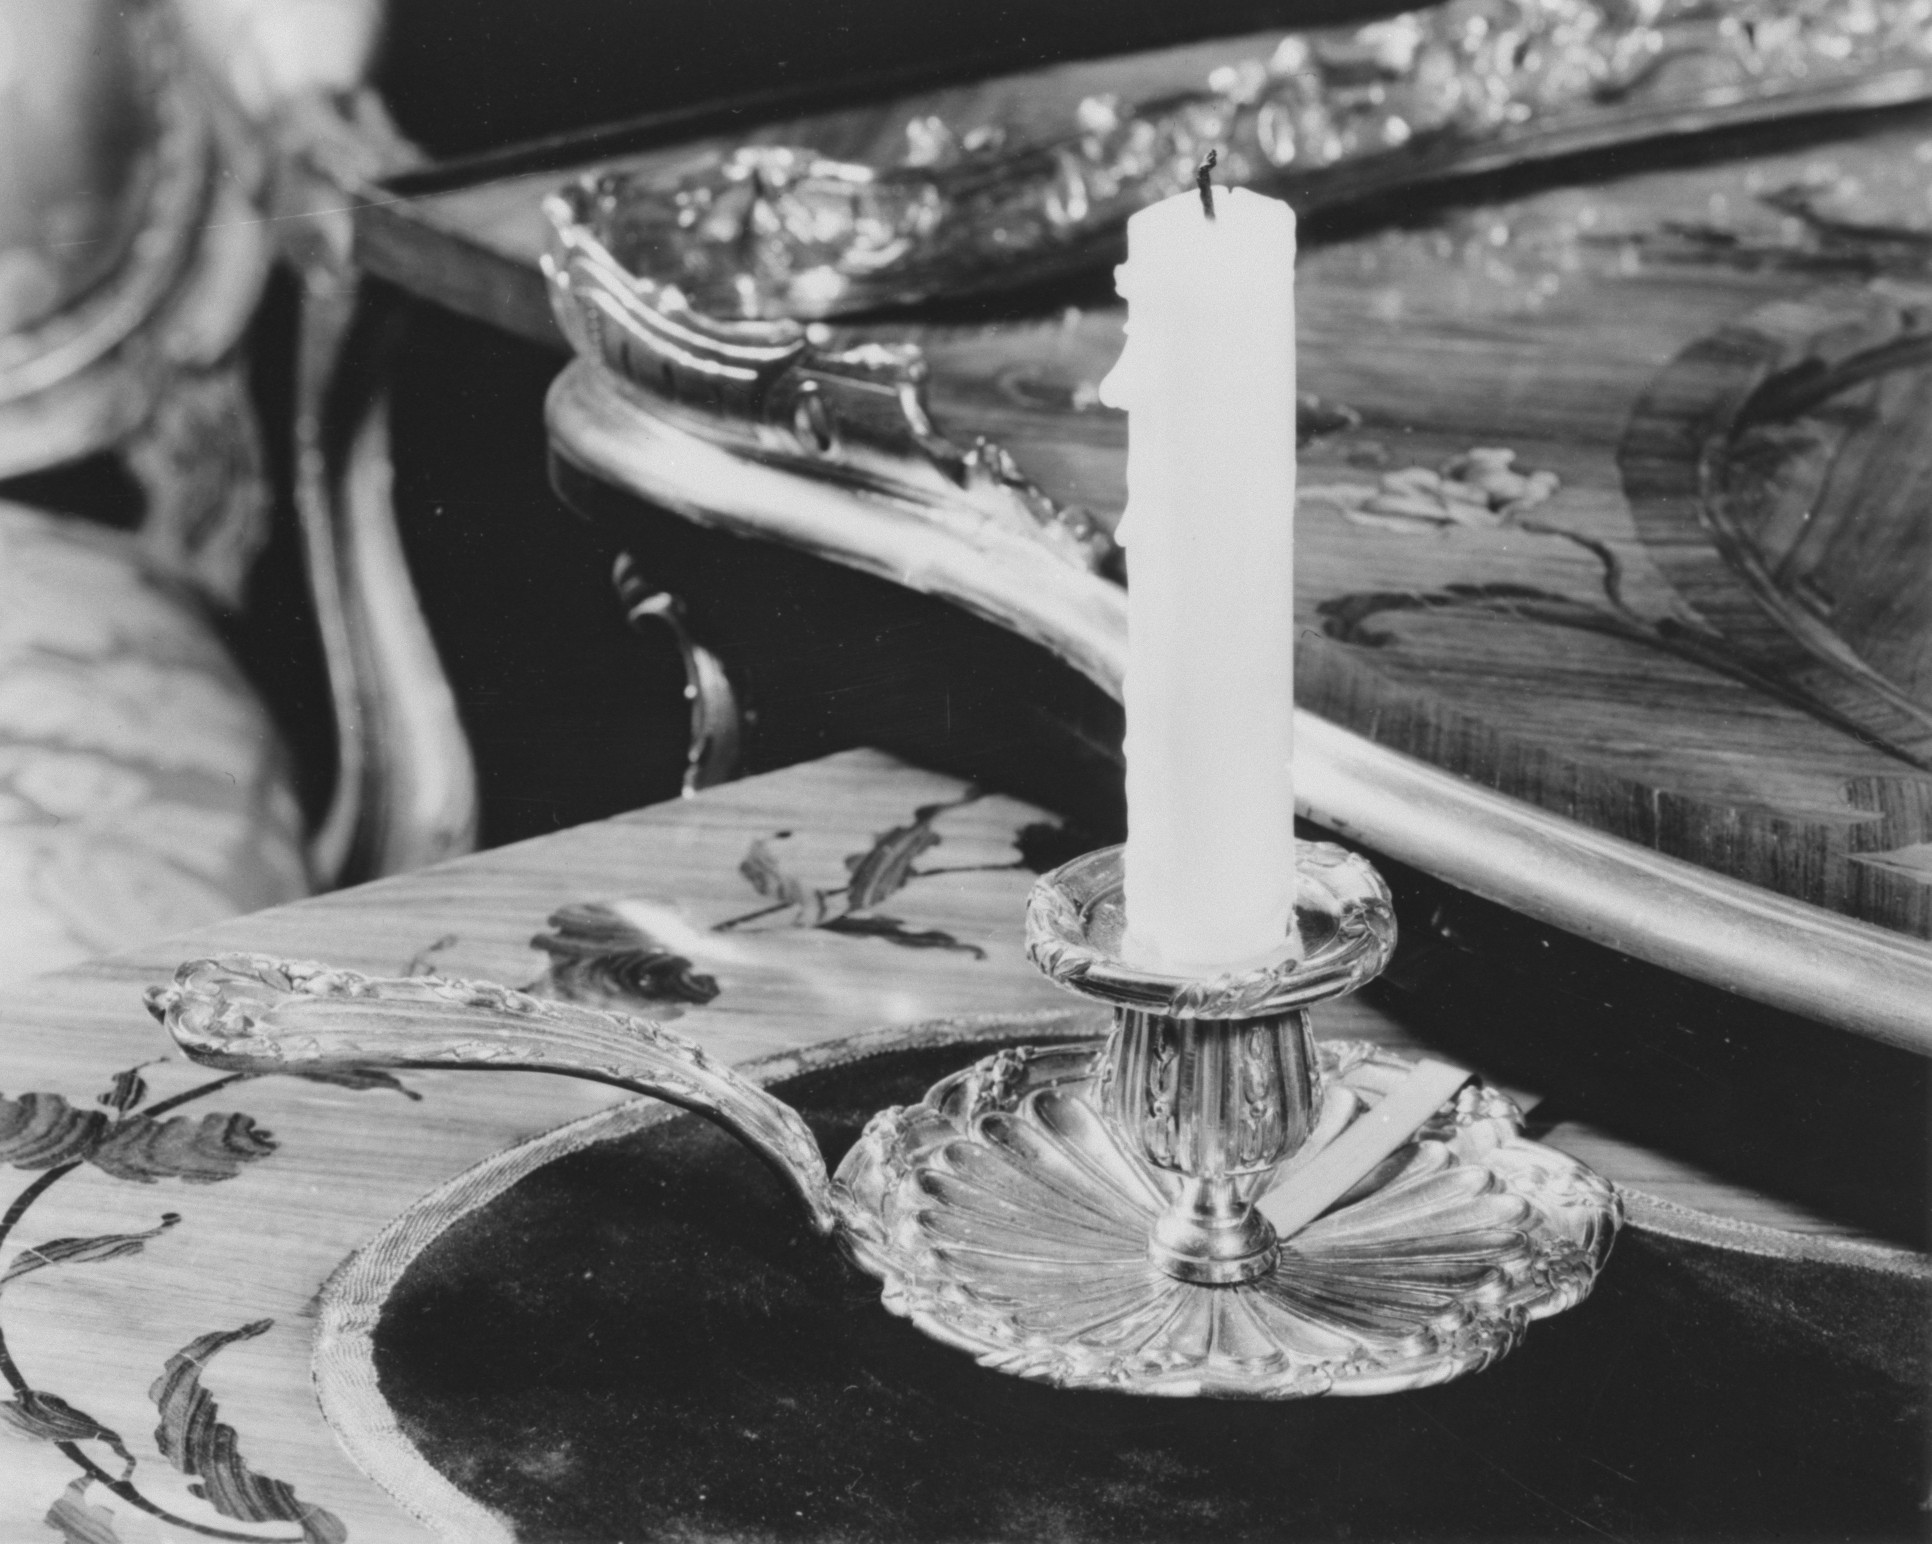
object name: chamber candlestick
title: Chamber candlestick (petit bougeoir)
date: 1751-1775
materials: gilt bronze